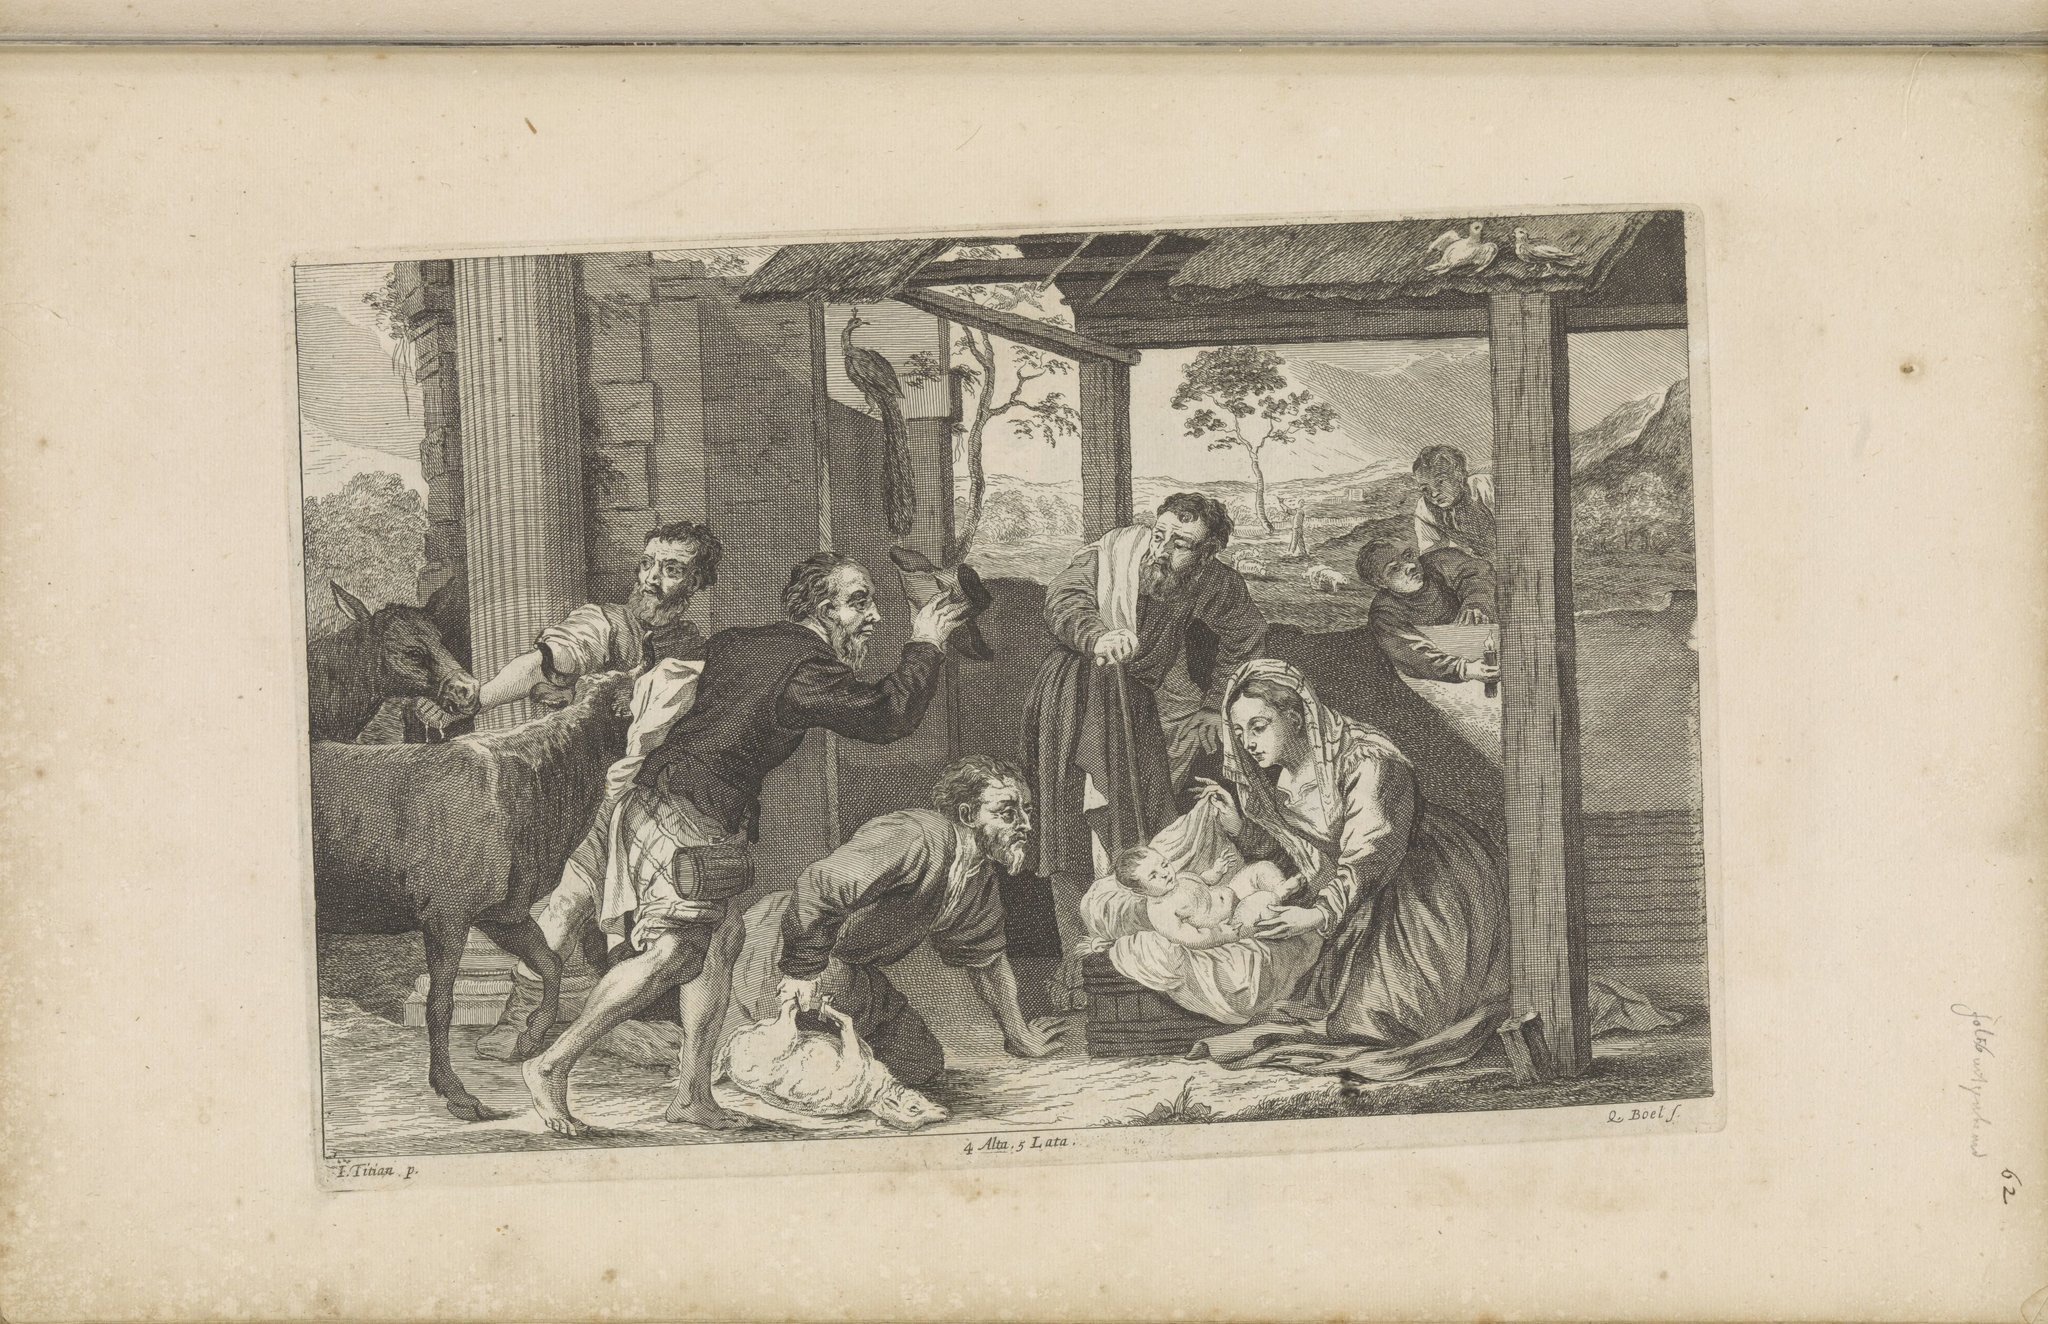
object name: print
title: Aanbidding door de herders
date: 1660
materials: paper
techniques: engraving, etching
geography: southern netherlands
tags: adoration of the christ-child by the shepherds; mary and joseph present, other birds: dove, ornamental birds: peacock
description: David Teniers heeft waarschijnlijk van alle schilderijen uit de collectie van Leopold Willem van Oostenrijk een olieverfstudie op doek of paneel vervaardigd (zgn. pasticcio), die als voorbeeld voor de prentmakers diende. Het is niet altijd duidelijk of de pasticci door hem zijn gemaakt of door zijn atelier. Niet alle pasticci zijn overgeleverd.